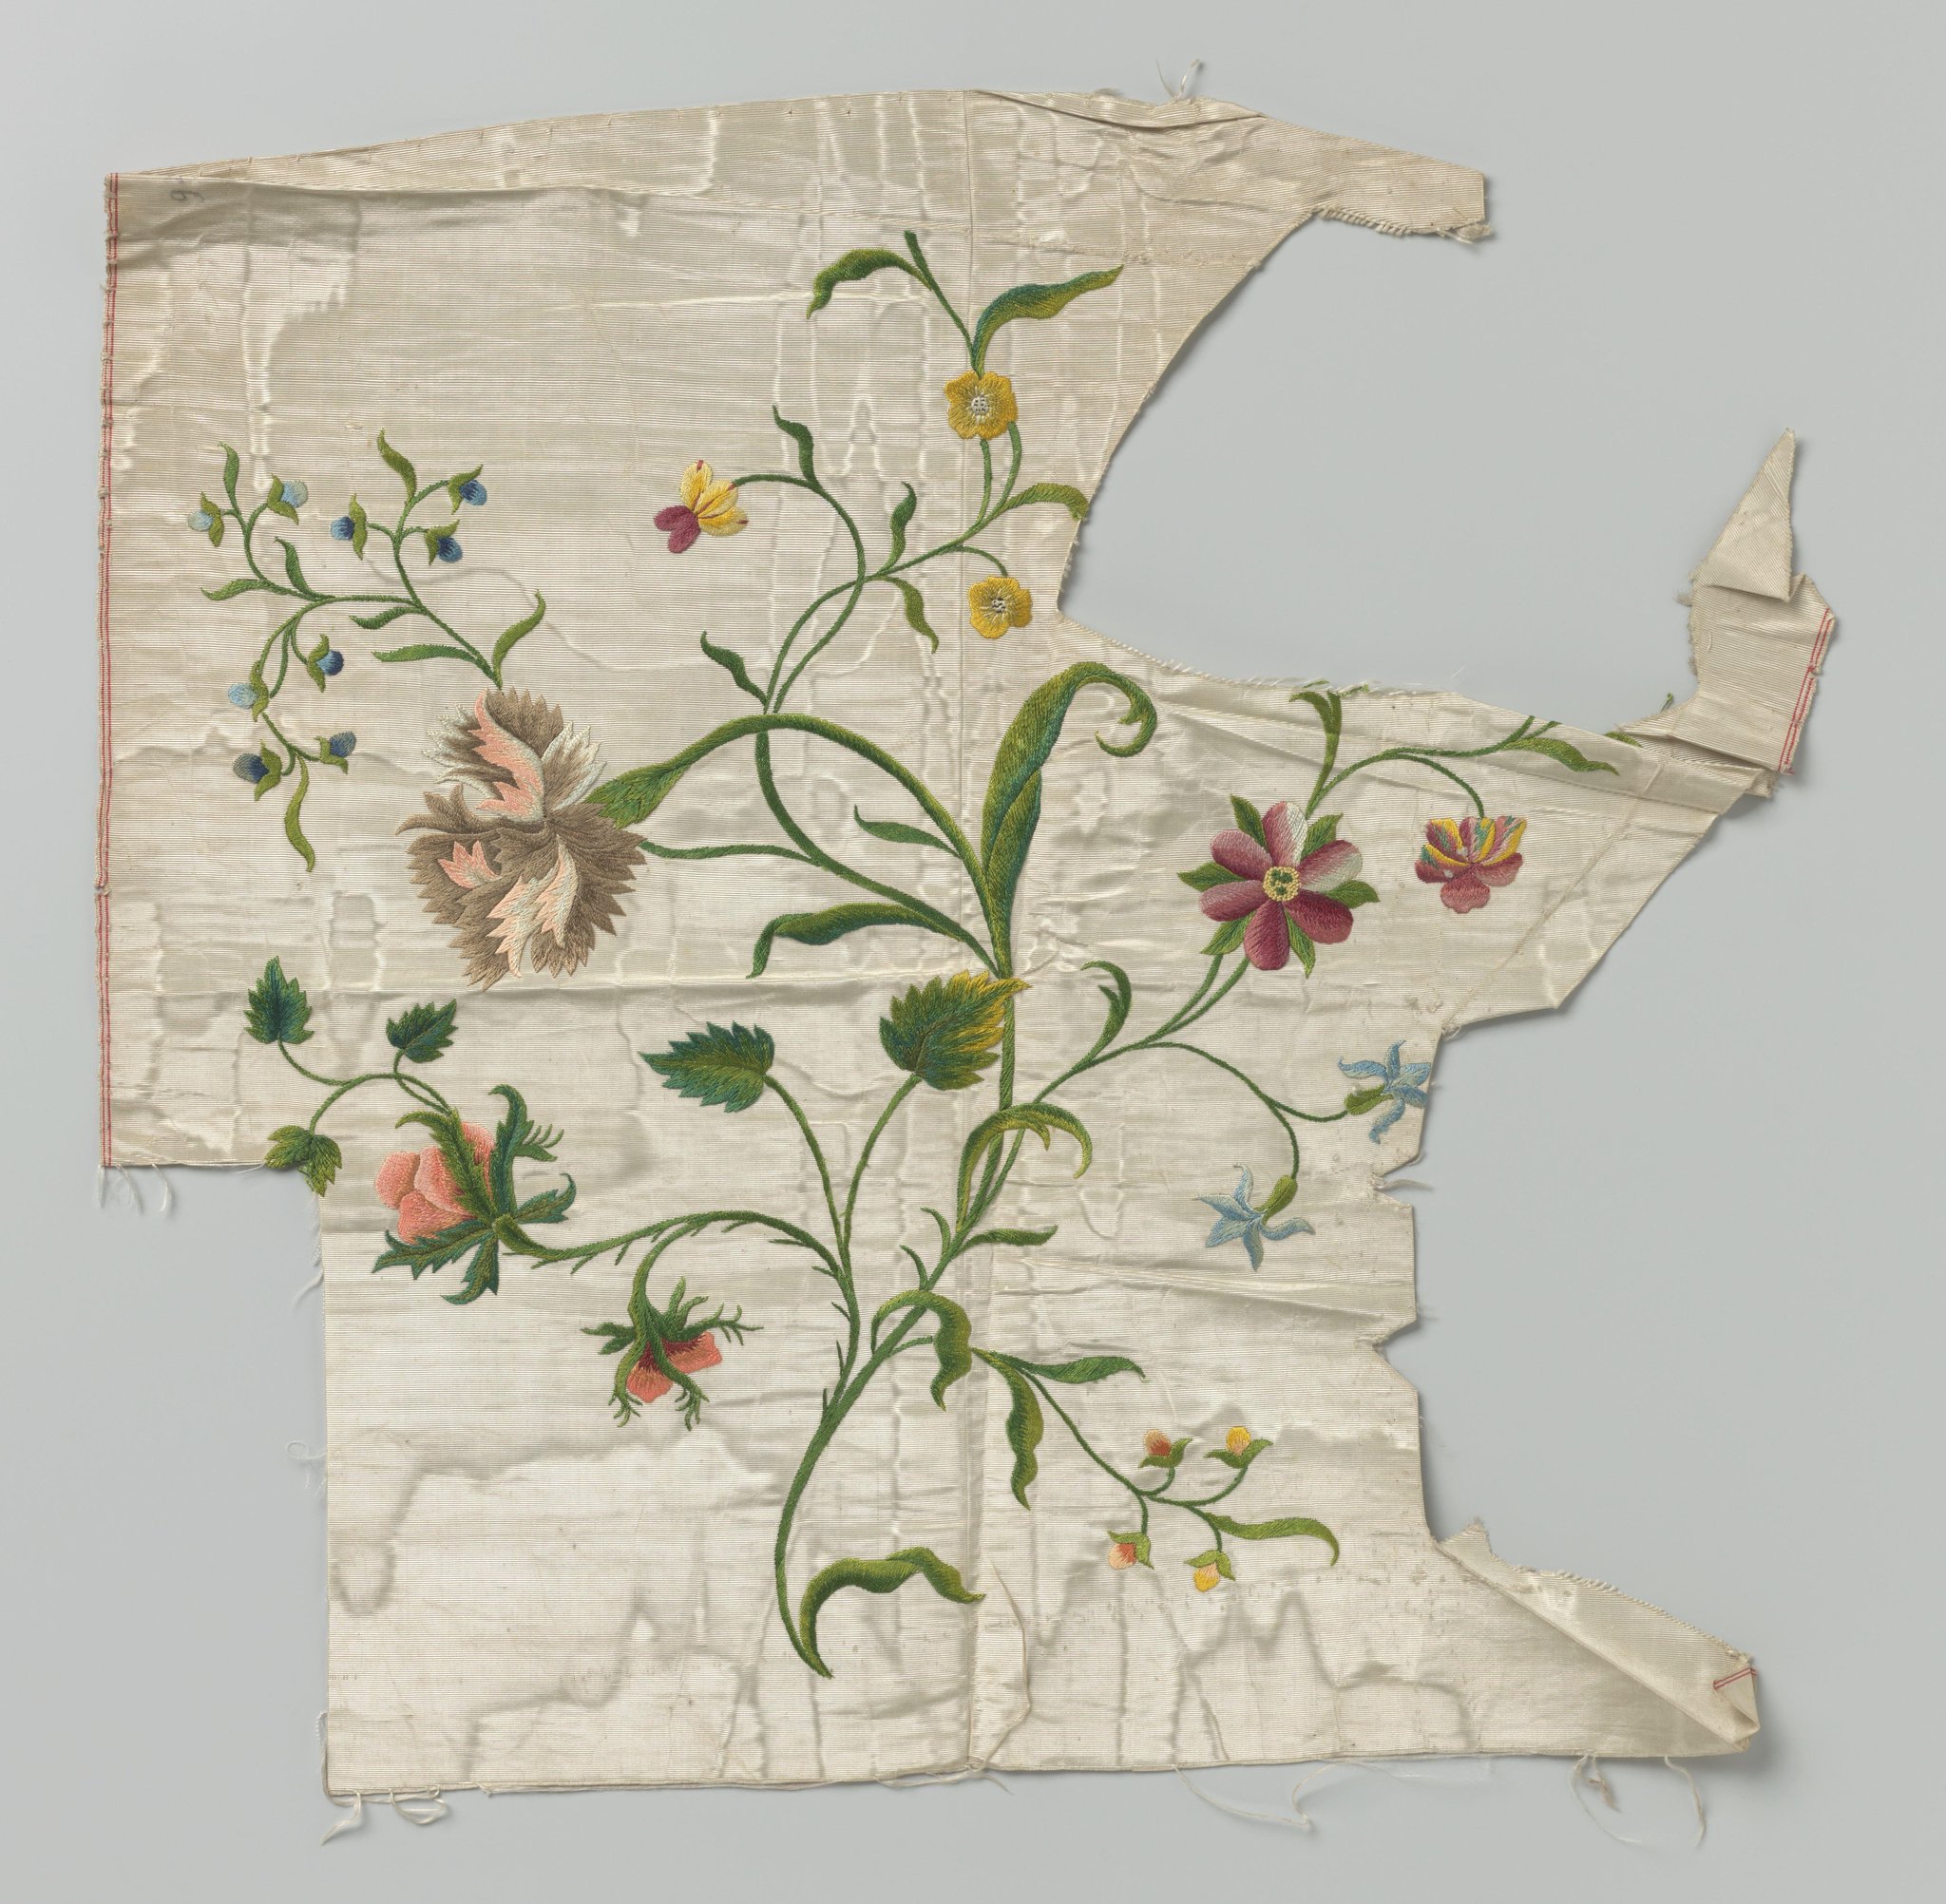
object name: lap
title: Lap van geborduurde zijde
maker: Anonymous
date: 1799-1800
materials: silk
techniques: moire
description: Fragment van witte ripszijde met moiré effect waarop een patroon van bloemen in roze, groen, blauw, wit en geel is geborduurd.